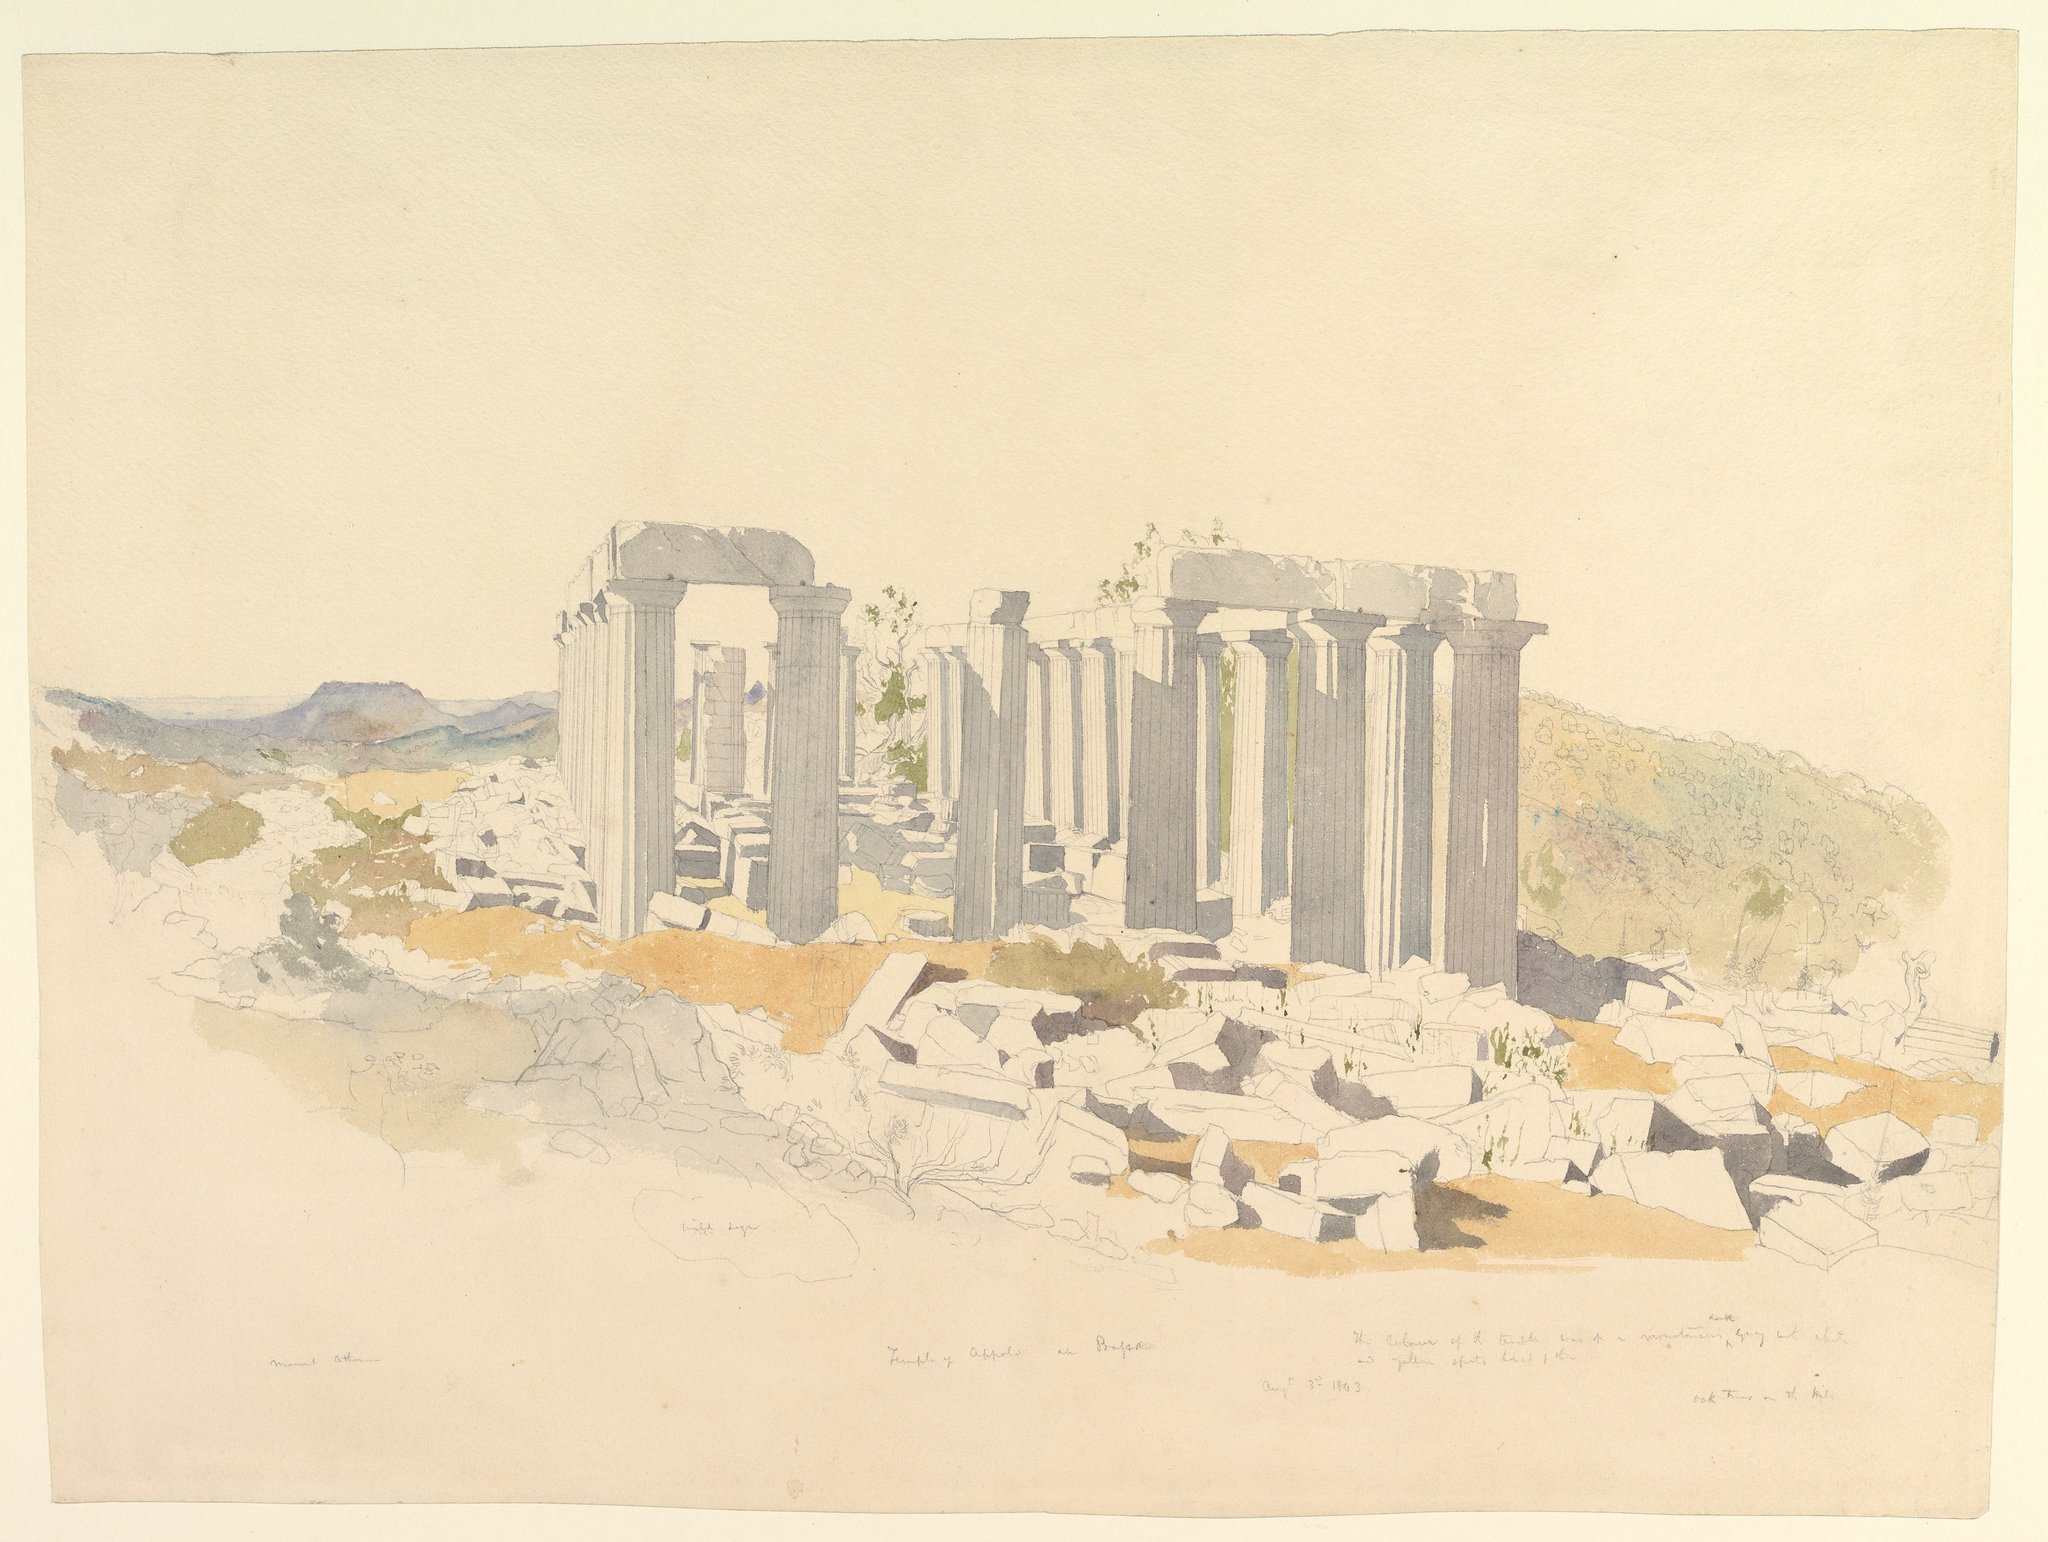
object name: drawing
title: The Temple of Apollo at Bassae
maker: thomas hartley cromek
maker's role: artist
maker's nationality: british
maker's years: 1809-1873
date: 1843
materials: graphite, watercolor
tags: temples,ruins